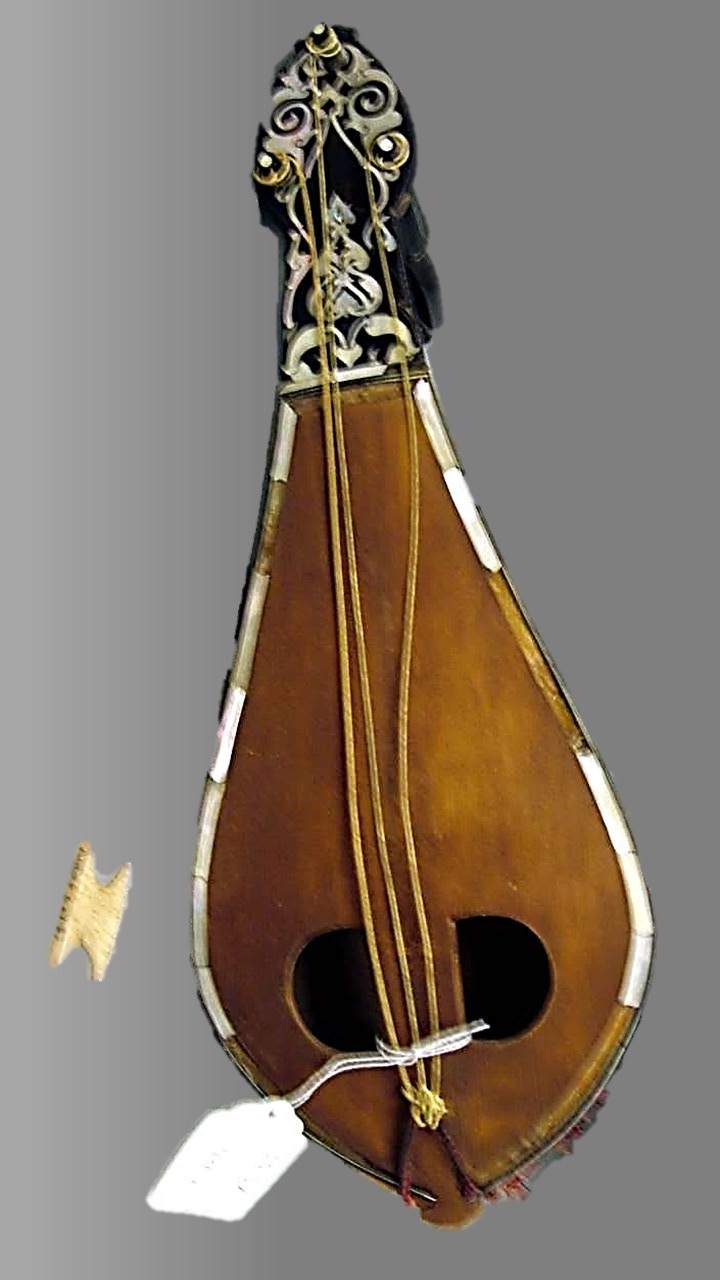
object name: kemençe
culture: turkish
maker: baron baronak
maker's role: maker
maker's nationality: armenian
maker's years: 1834-1900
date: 1801-1900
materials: pearl, shell, wood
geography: turkey